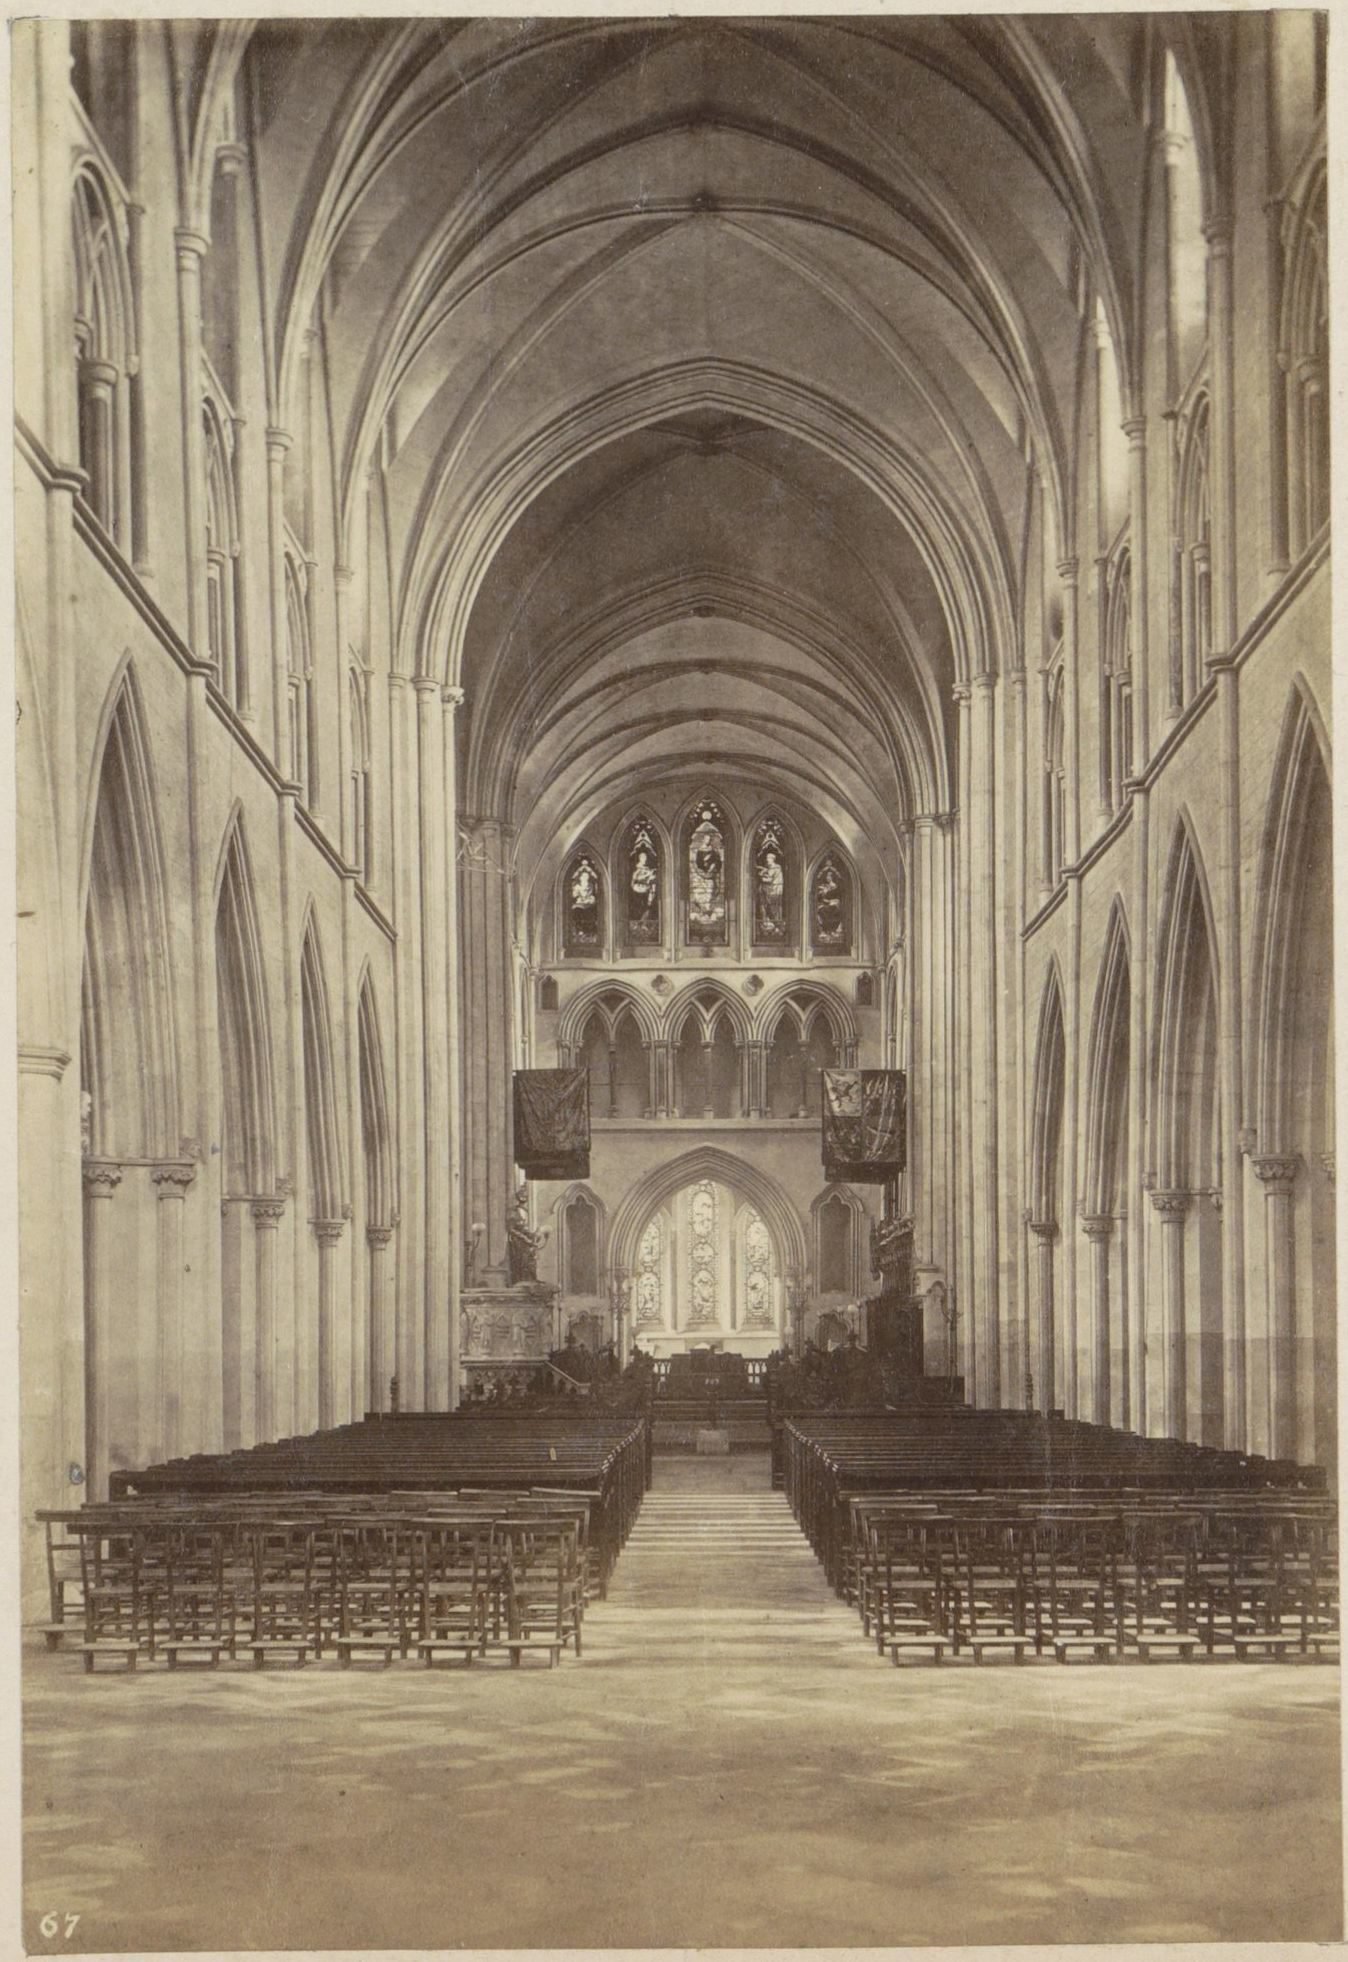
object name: photograph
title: Koor en schip van Saint Patrick's Cathedral in Dublin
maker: Anonymous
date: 1850-1870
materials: paper, photographic support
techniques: albumen print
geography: dublin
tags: parts of church interior: nave, parts of church interior: choir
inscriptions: negative number: ‘67’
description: Onderdeel van Album met foto's van bezienswaardigheden en landschappen in Engeland en van kunst.